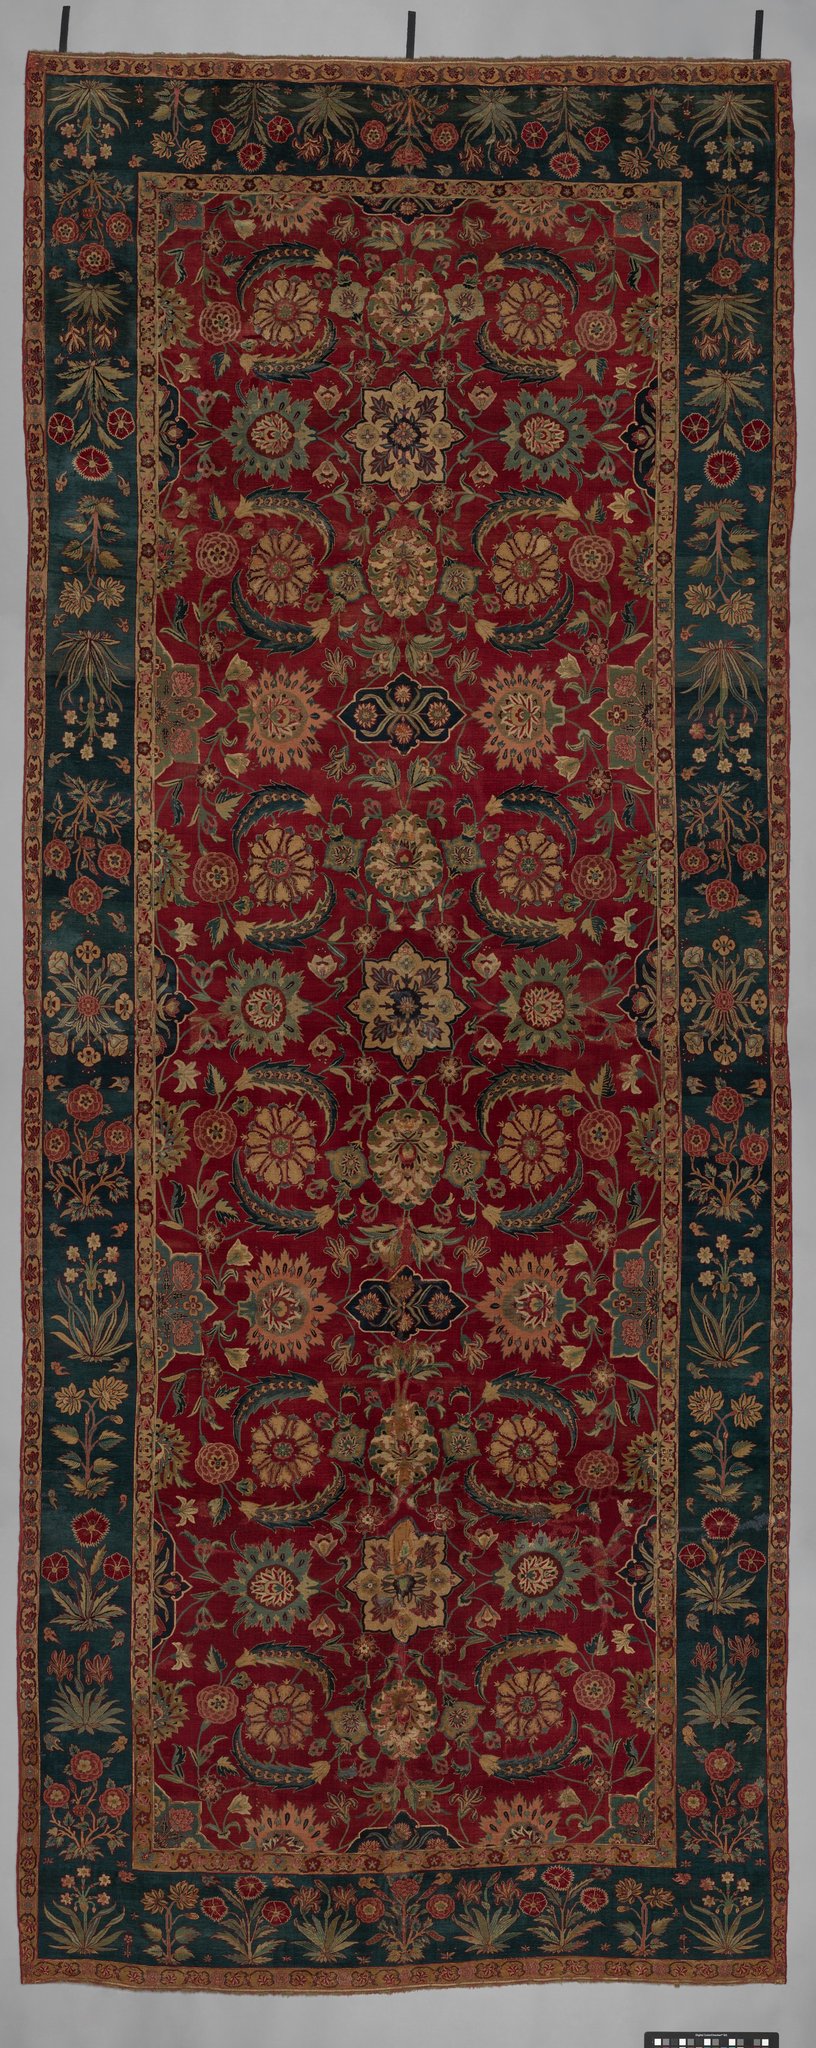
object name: carpet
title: Carpet with Scrolling Vines and Blossoms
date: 1650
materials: silk, wool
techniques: asymmetrically knotted pile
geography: india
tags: flowers,vines